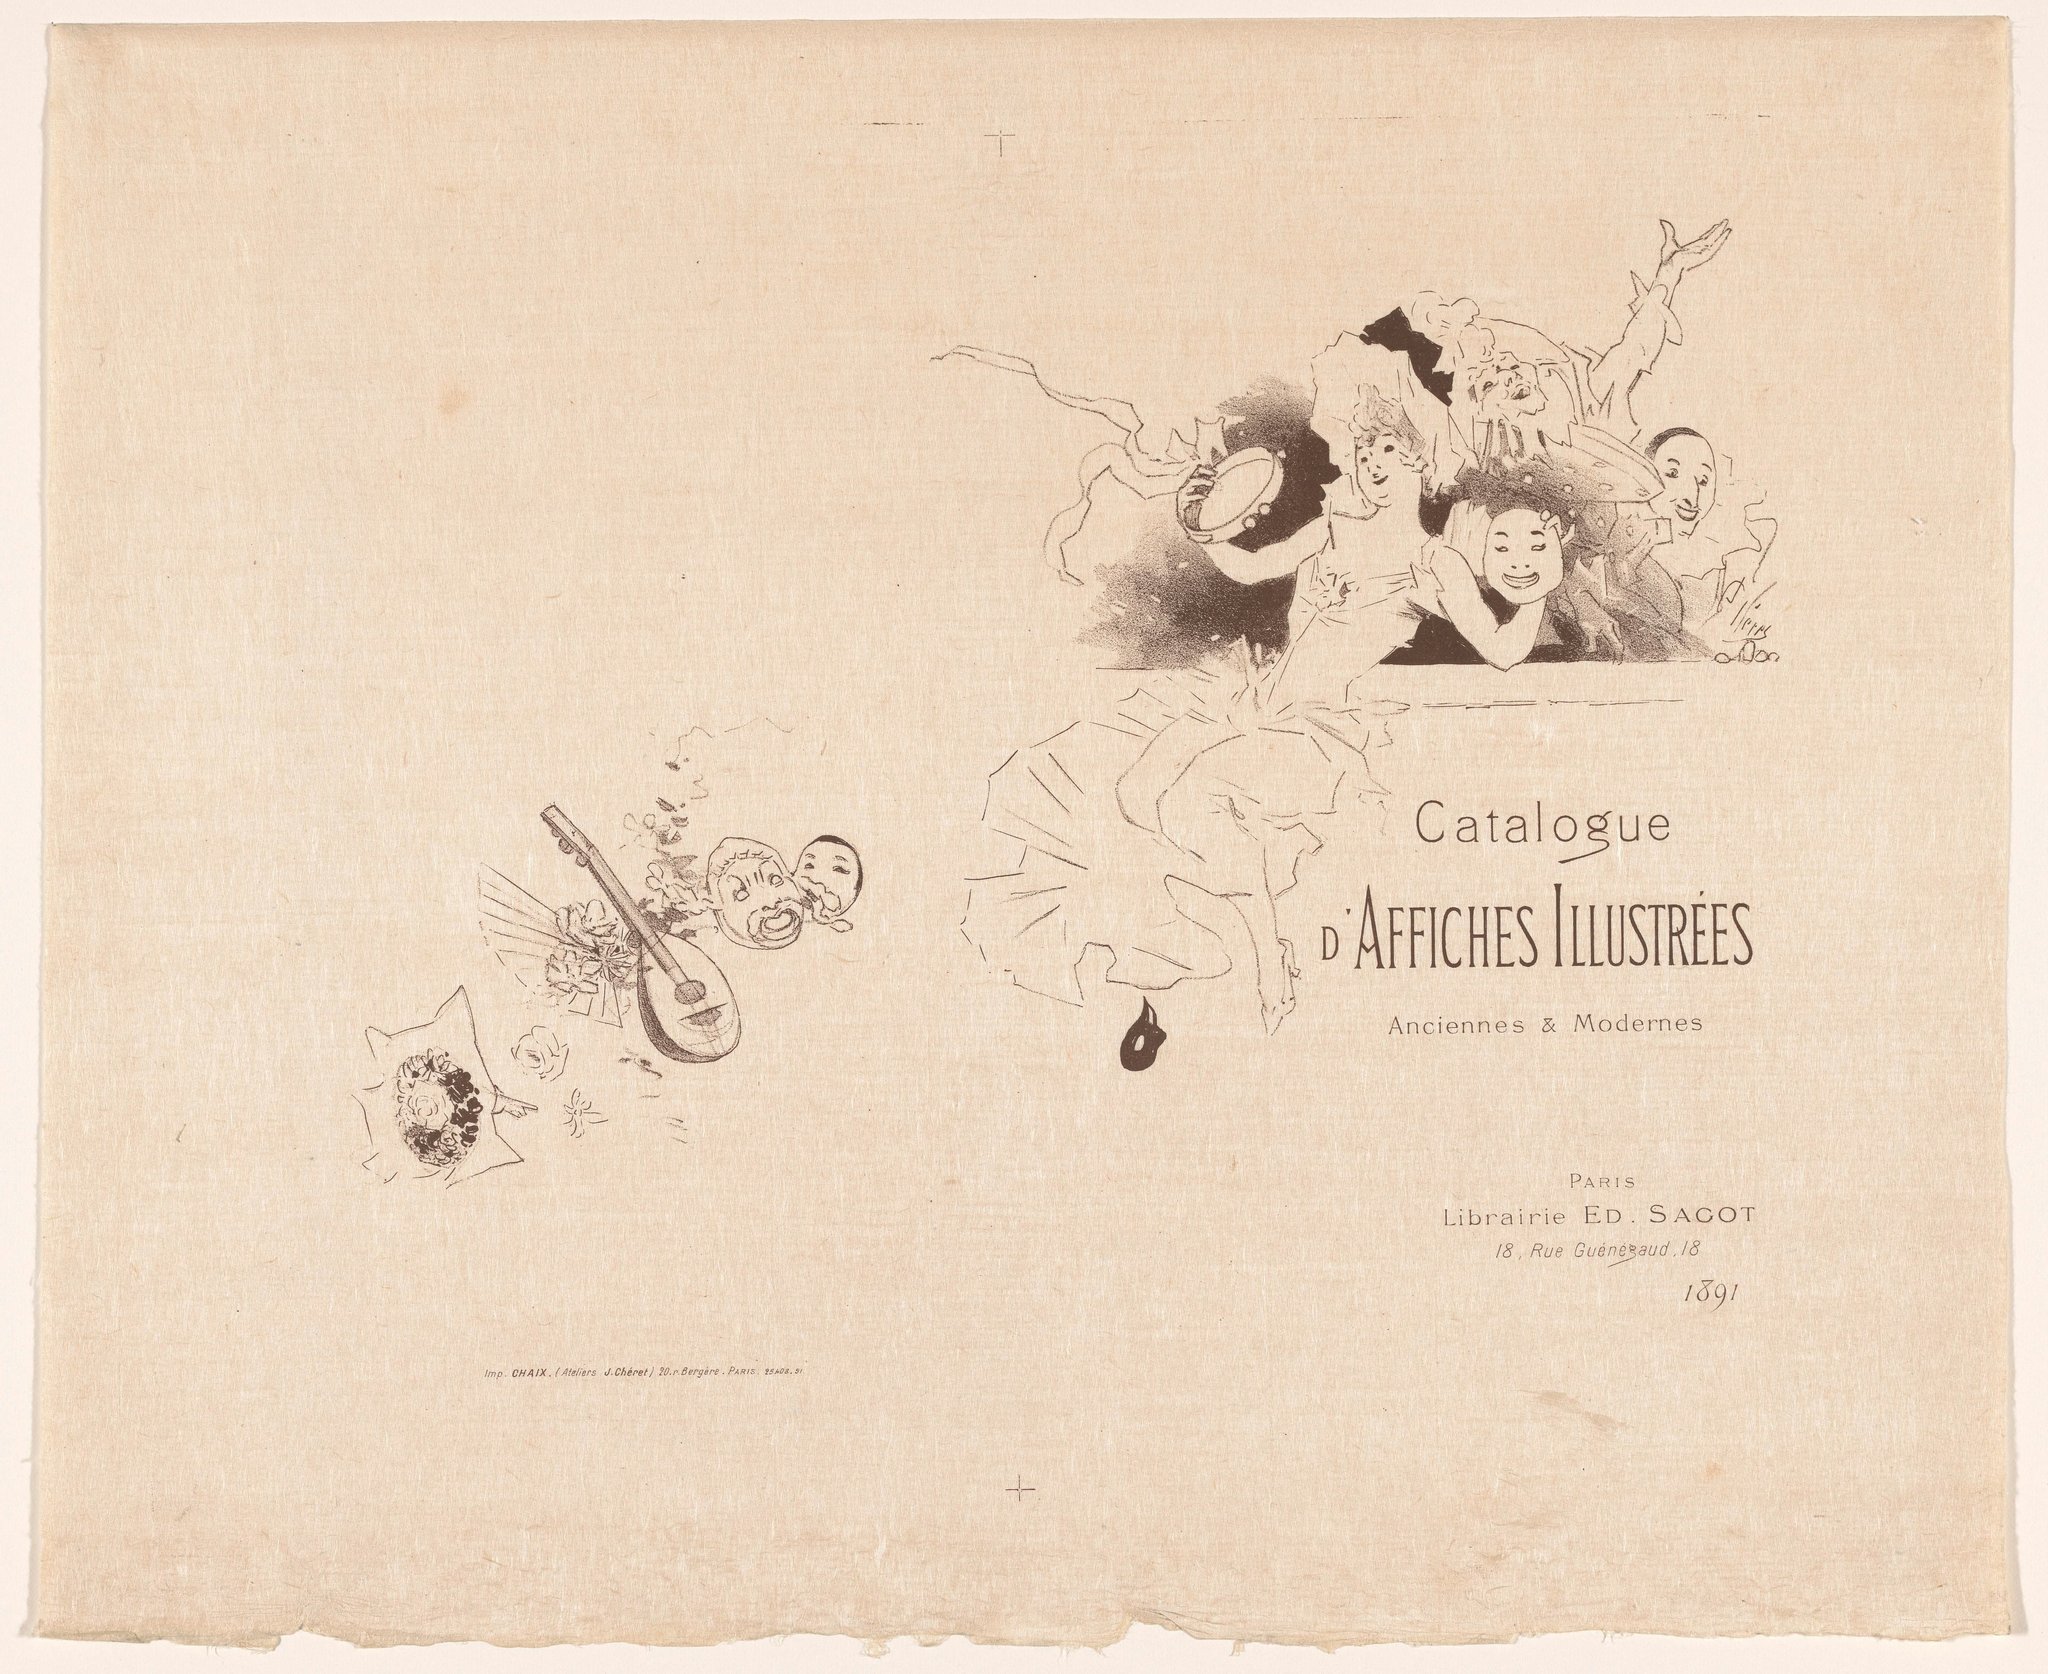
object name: wrapper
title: Danseres met in haar handen een masker en een tamboerijn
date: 1891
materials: paper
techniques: lithograph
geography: paris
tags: mask, tambourine, female dancer, cithern, mandolin, guitar, balalaika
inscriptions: collector's mark: Lugt 2228, collector's mark: Lugt 4779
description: Proefdruk van de omslag voor: Catalogue d'Affiches Illustrées Anciennes & Modernes. Parijs: Ed. Sagot, 1891.